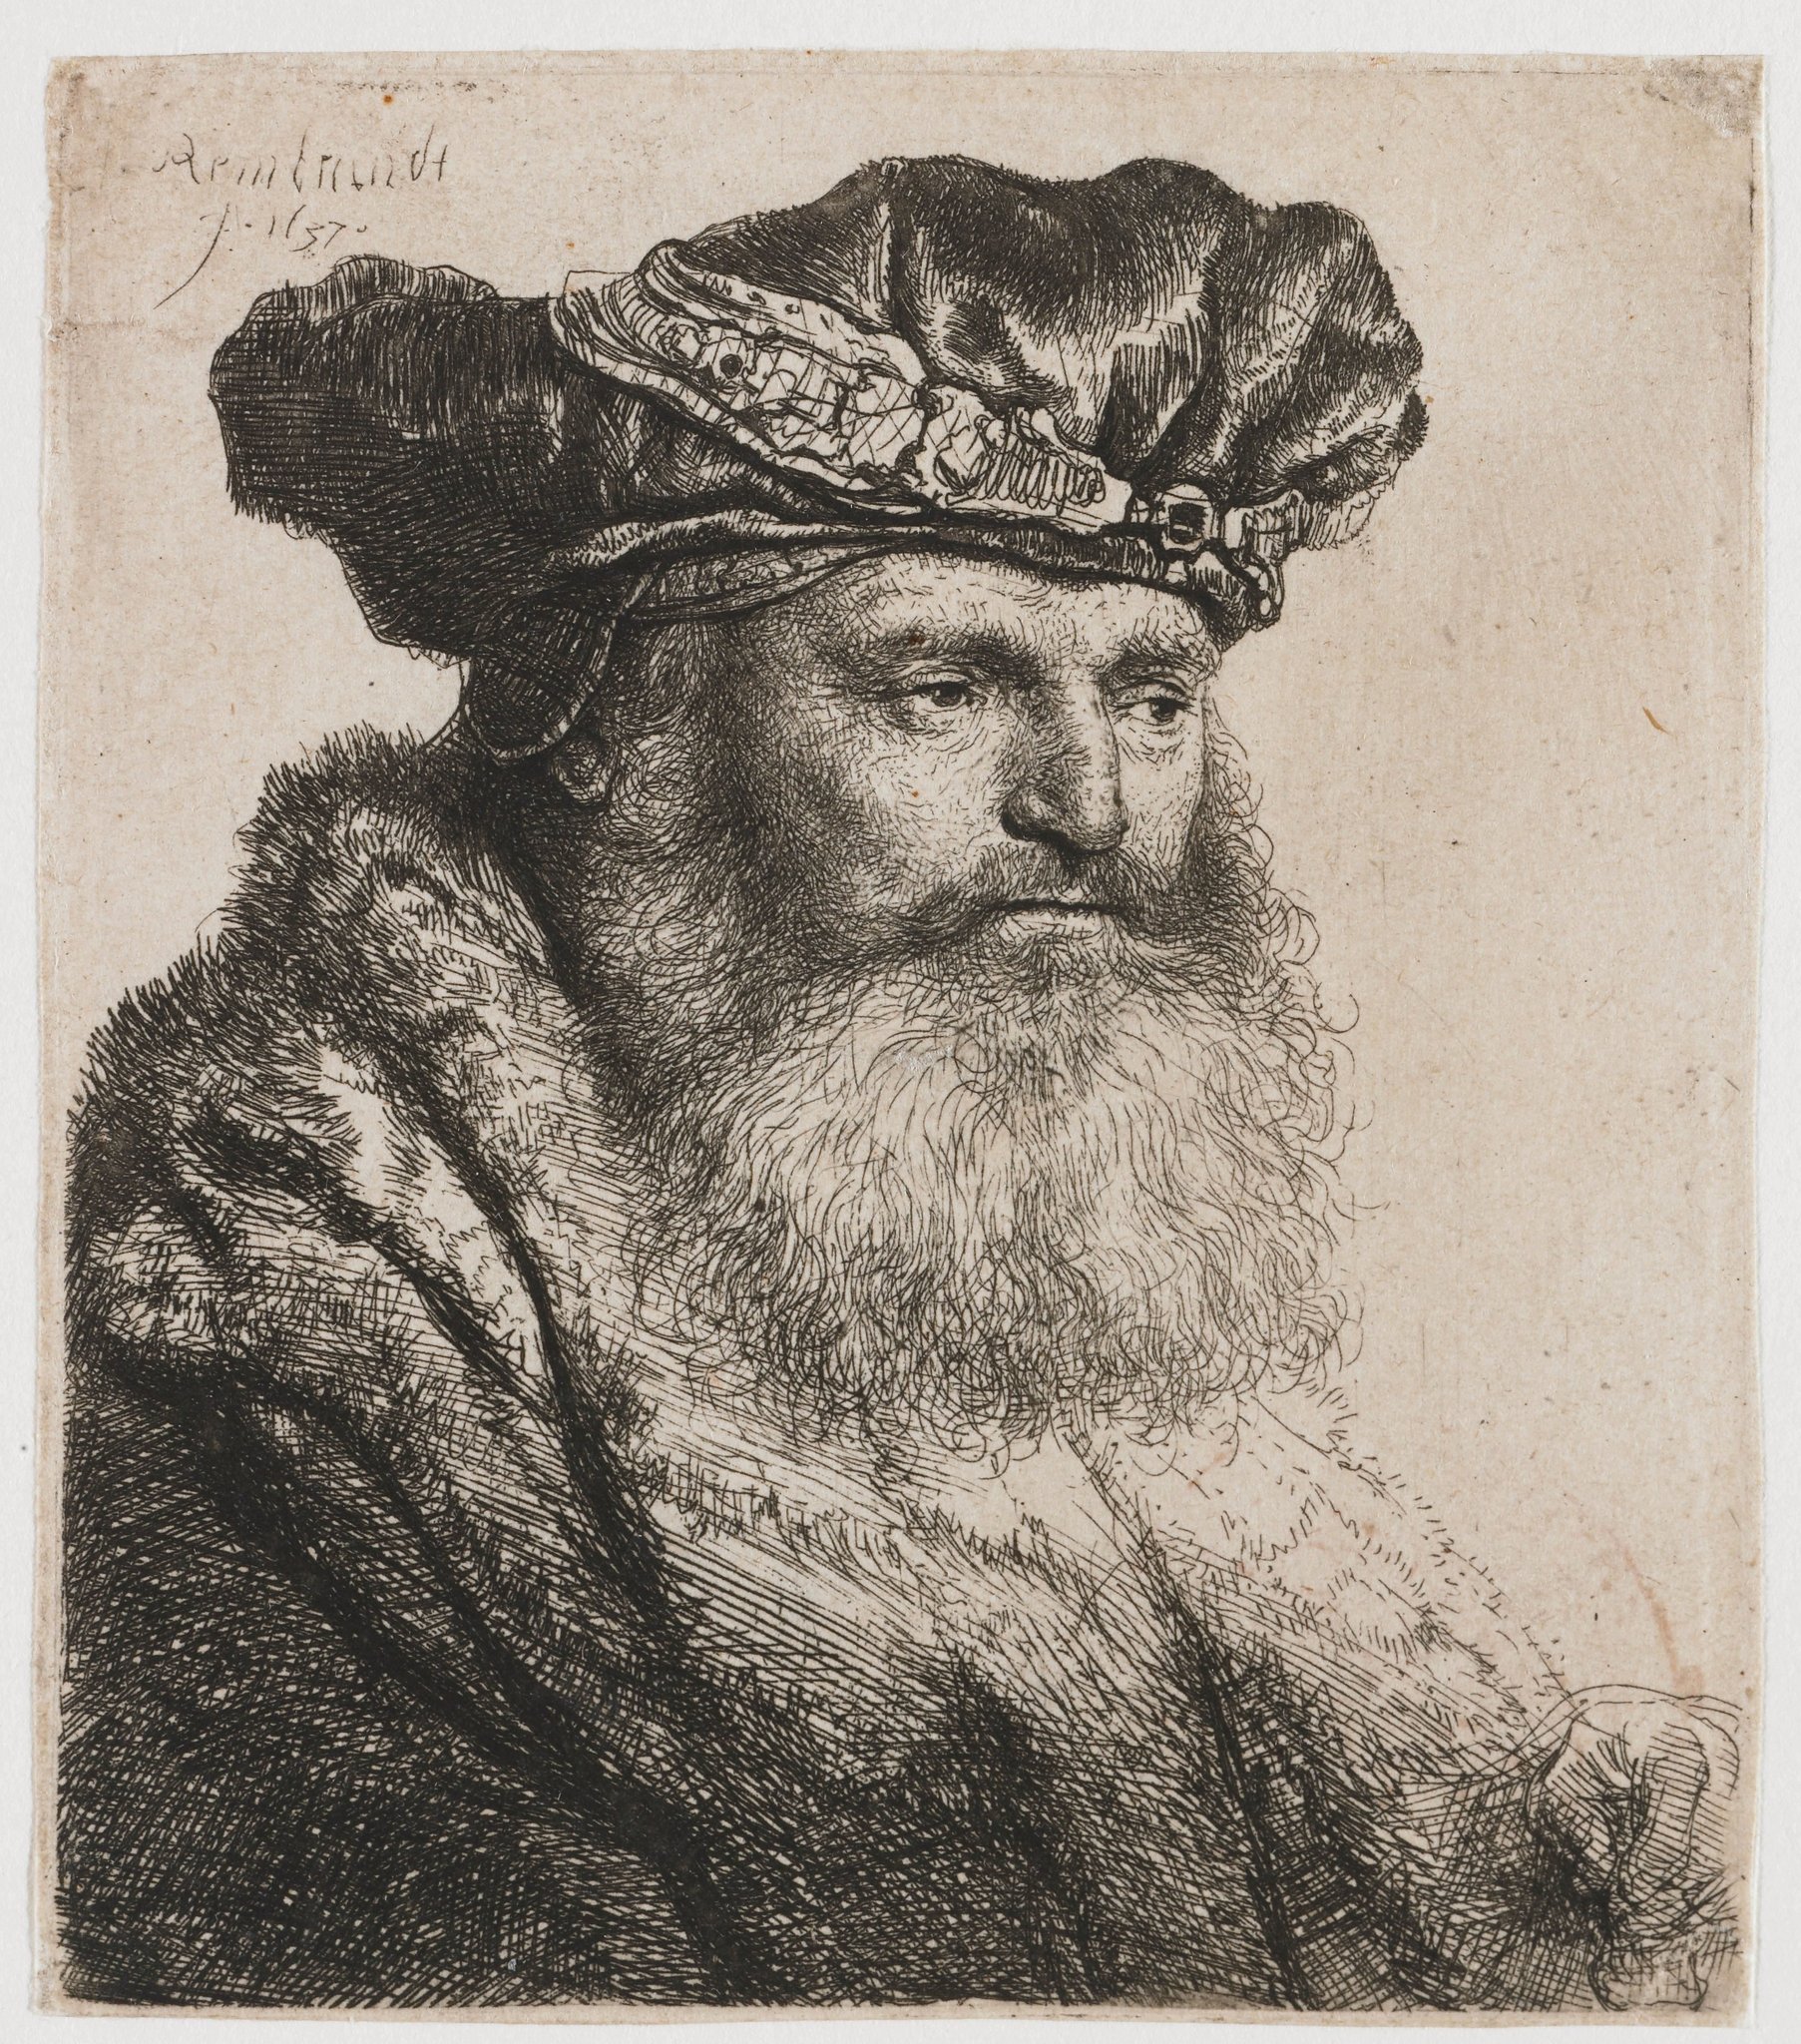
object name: print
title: Bearded man in a velvet cap with a jewel clasp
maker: rembrandt van rijn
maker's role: draughtsman, painter, print maker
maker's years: 1606-1669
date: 1637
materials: paper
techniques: etching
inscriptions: signature and date: ‘Rembrandt f 1637’, collector's mark: Lugt 240